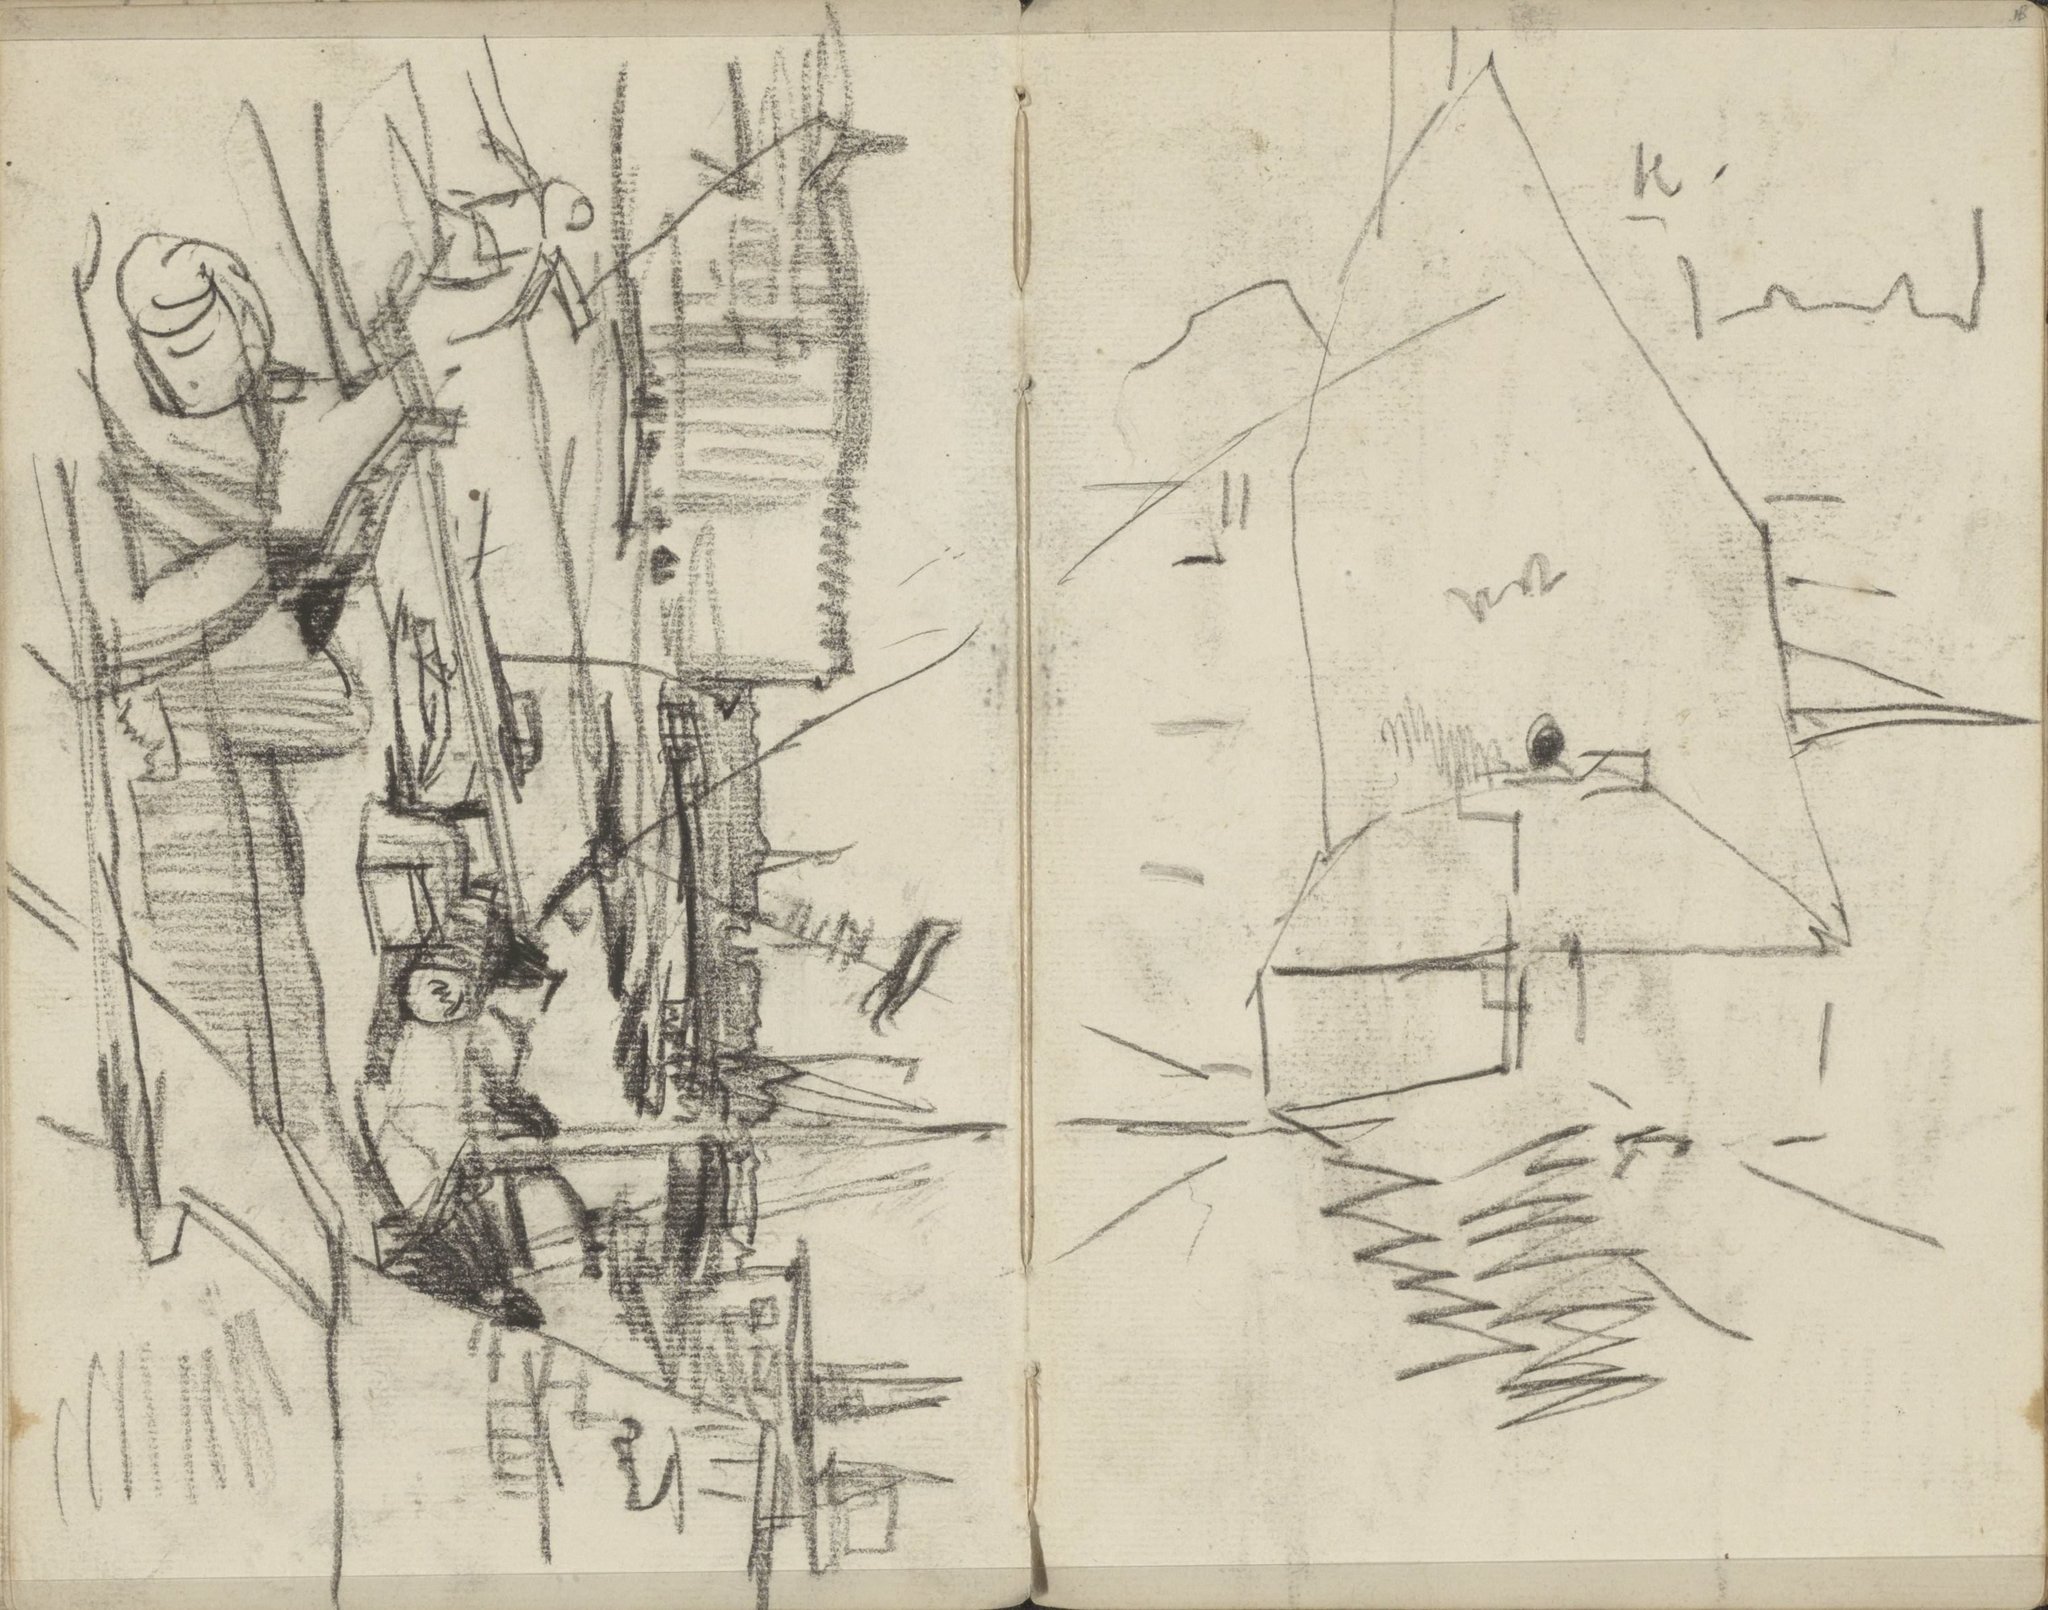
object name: sketchbook leaf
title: Gezicht op een kade met bouwmaterieel, mogelijk bij Prinseneiland te Amsterdam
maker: george hendrik breitner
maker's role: draughtsman, painter, print maker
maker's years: 1857-1923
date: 1886-1903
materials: chalk, paper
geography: amsterdam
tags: building materials, ships (in general), architecture, quay (+ city(-scape) with figures, staffage), civic architecture; edifices; dwellings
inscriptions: kleurnotitie, handgeschreven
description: Op het andere blad mogelijk een architectuurstudie. Pagina 17 en pagina 18 uit een schetsboek met 15 bladen.